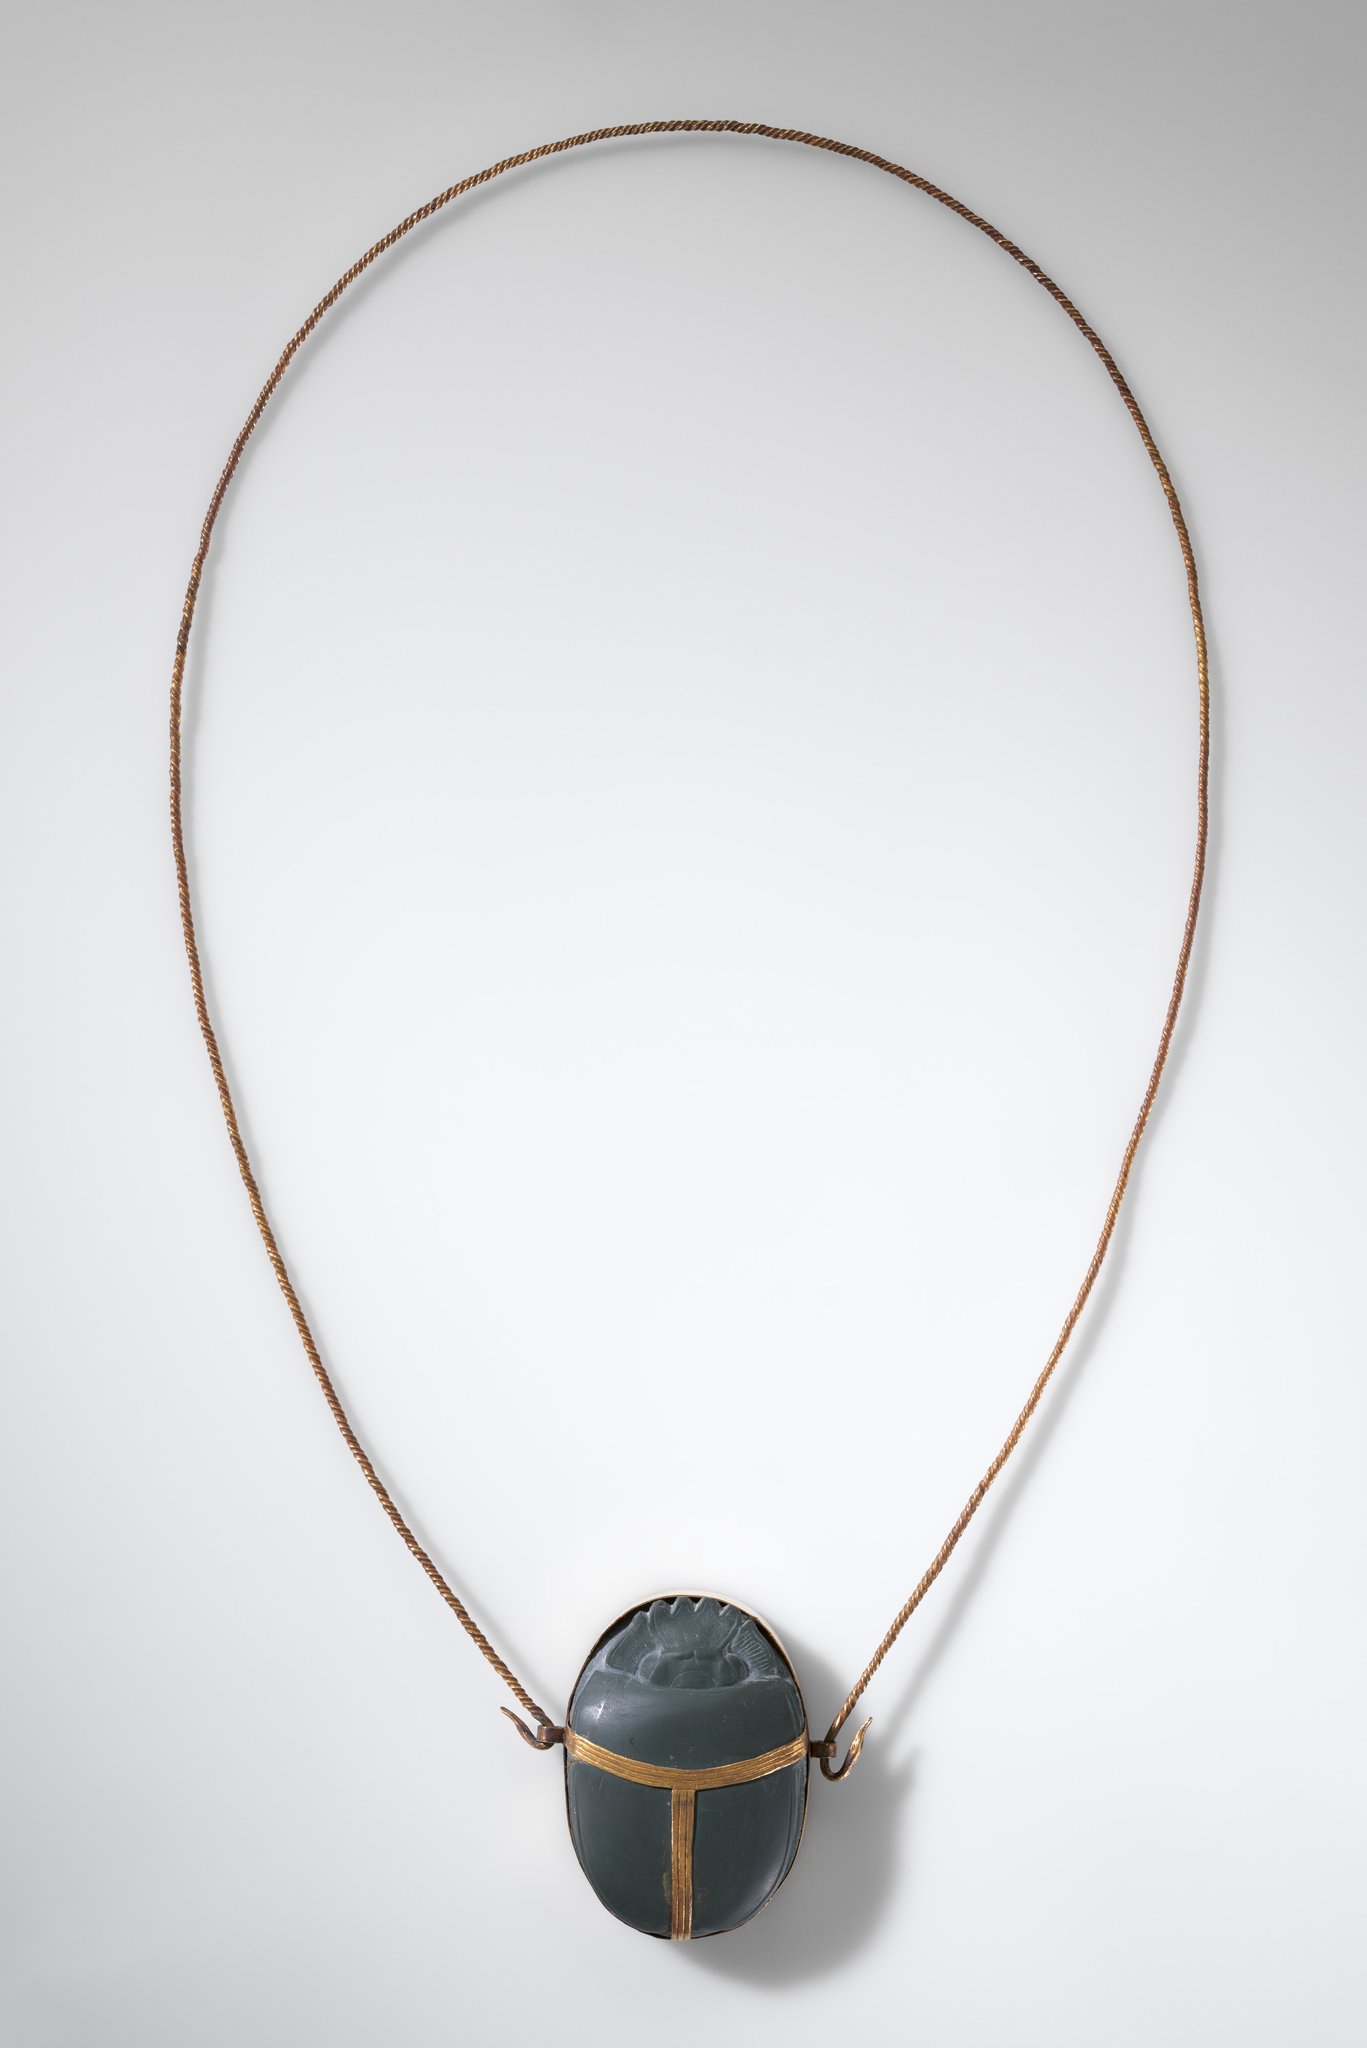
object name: heart scarab, manuwai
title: Heart Scarab of Manuwai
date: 1479-1425 BCE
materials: gold, stone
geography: egypt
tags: scarabs